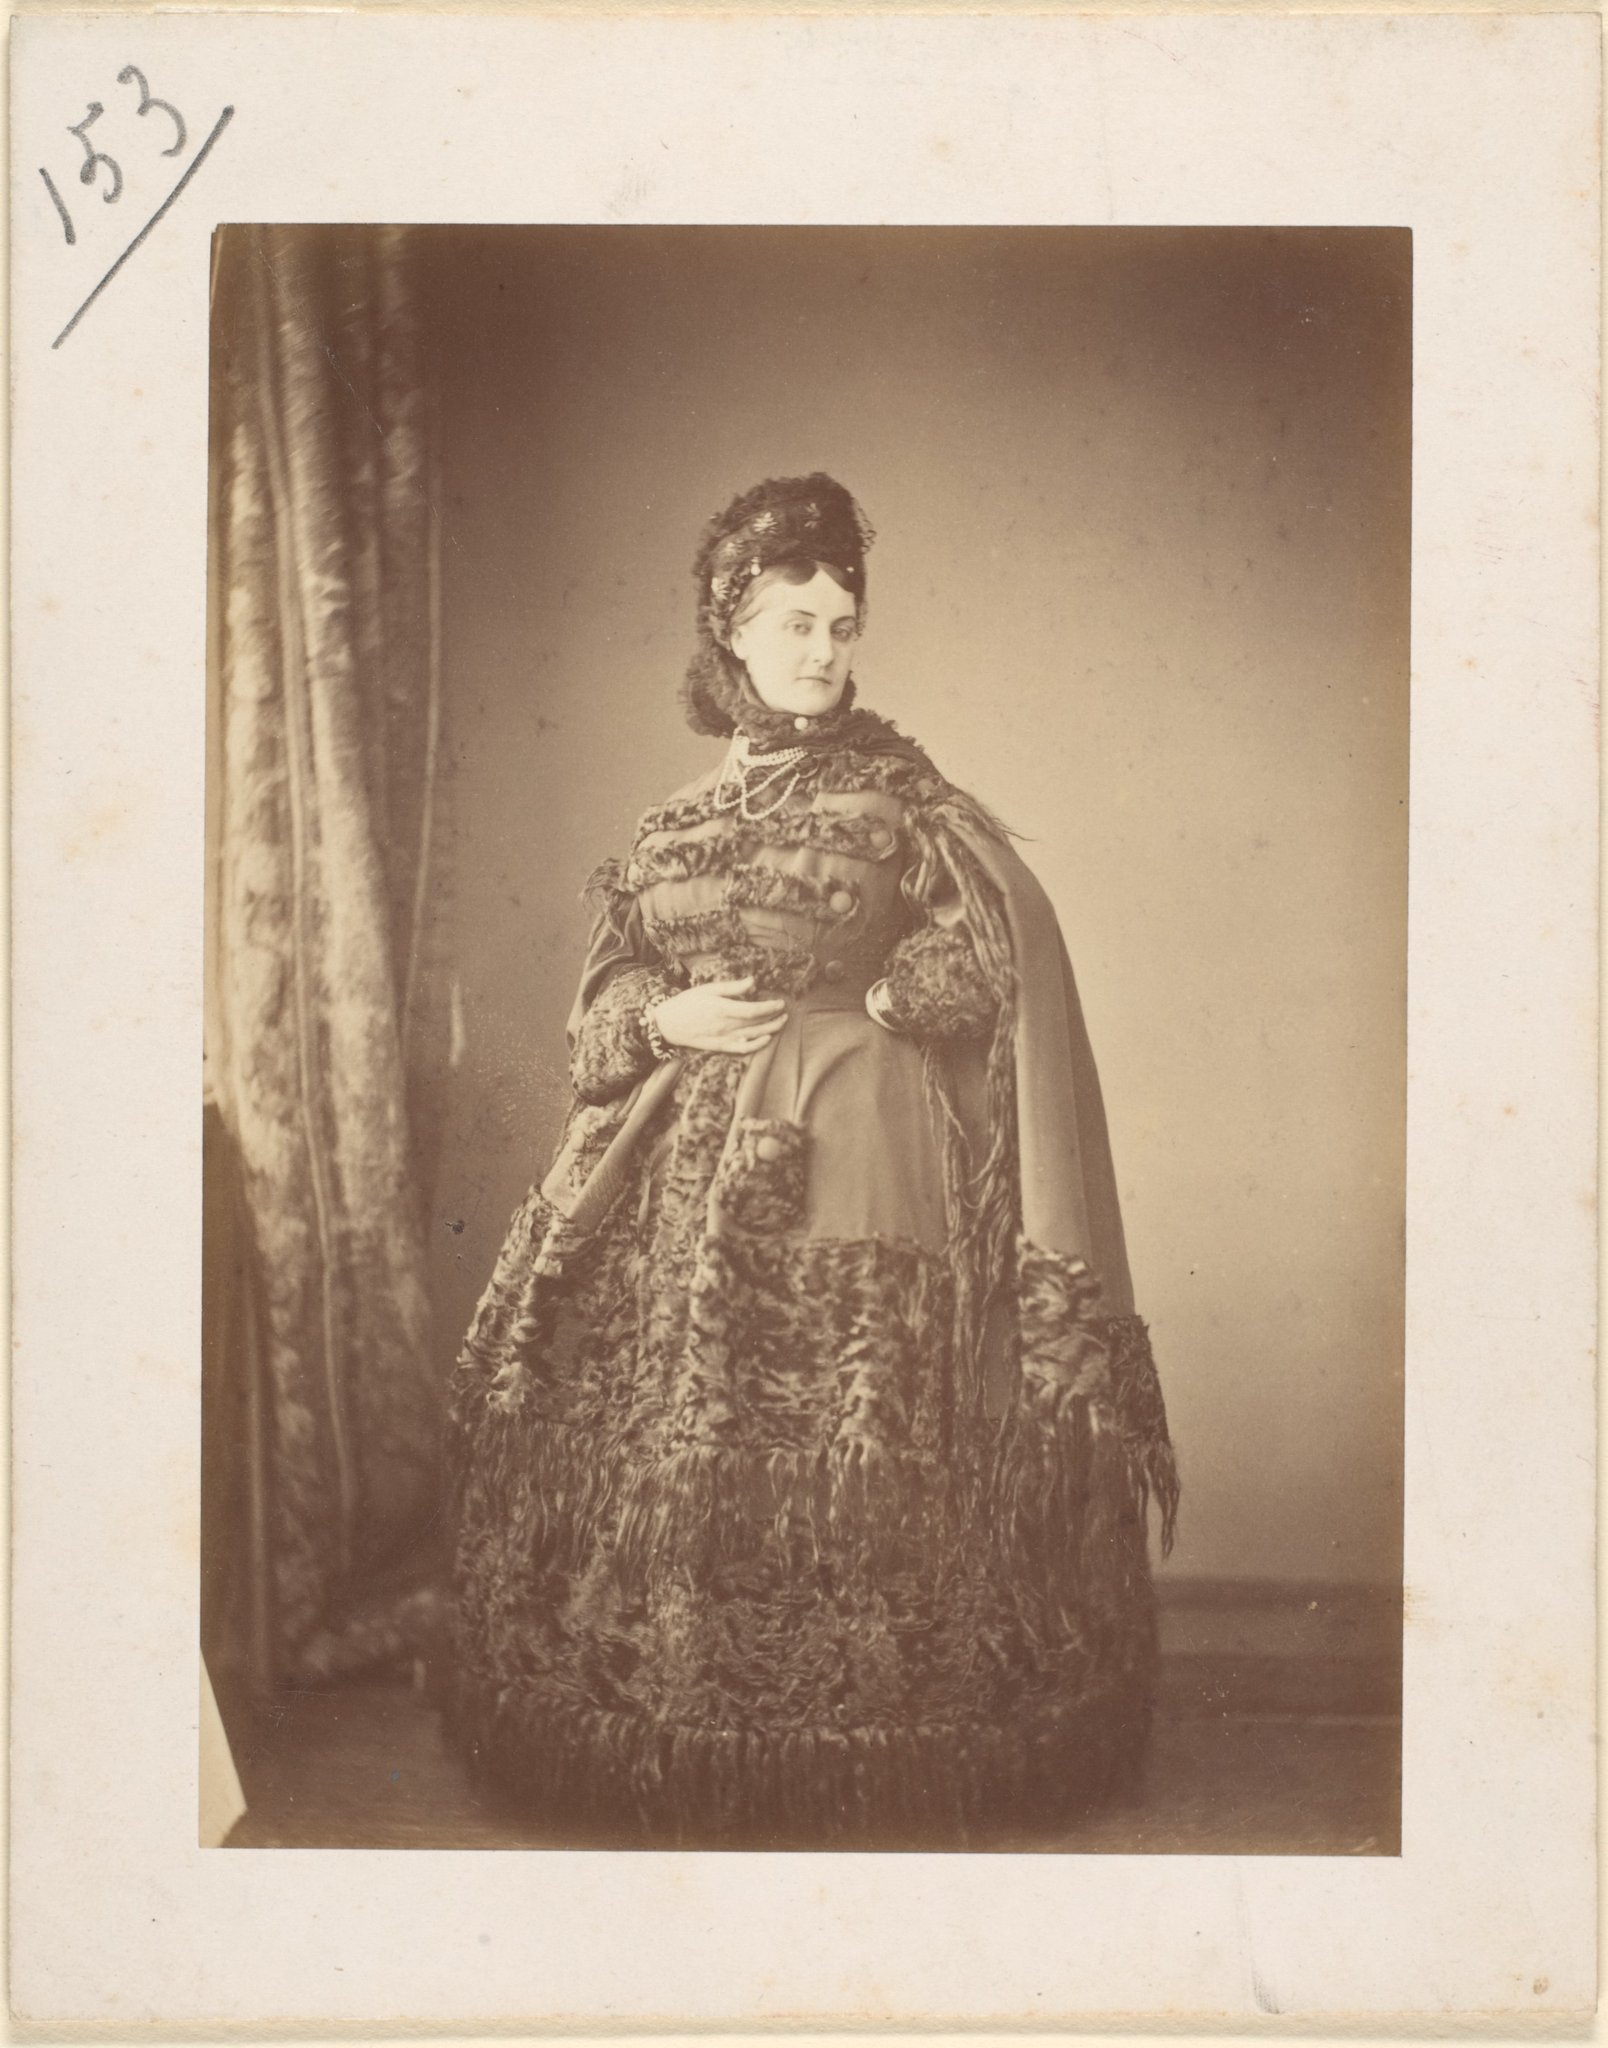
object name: photograph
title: Le Caracul (L'Astrakhan)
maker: pierre-louis pierson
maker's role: artist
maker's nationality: french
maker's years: 1822-1913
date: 1860-1869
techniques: albumen silver print, glass negative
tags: portraits,women